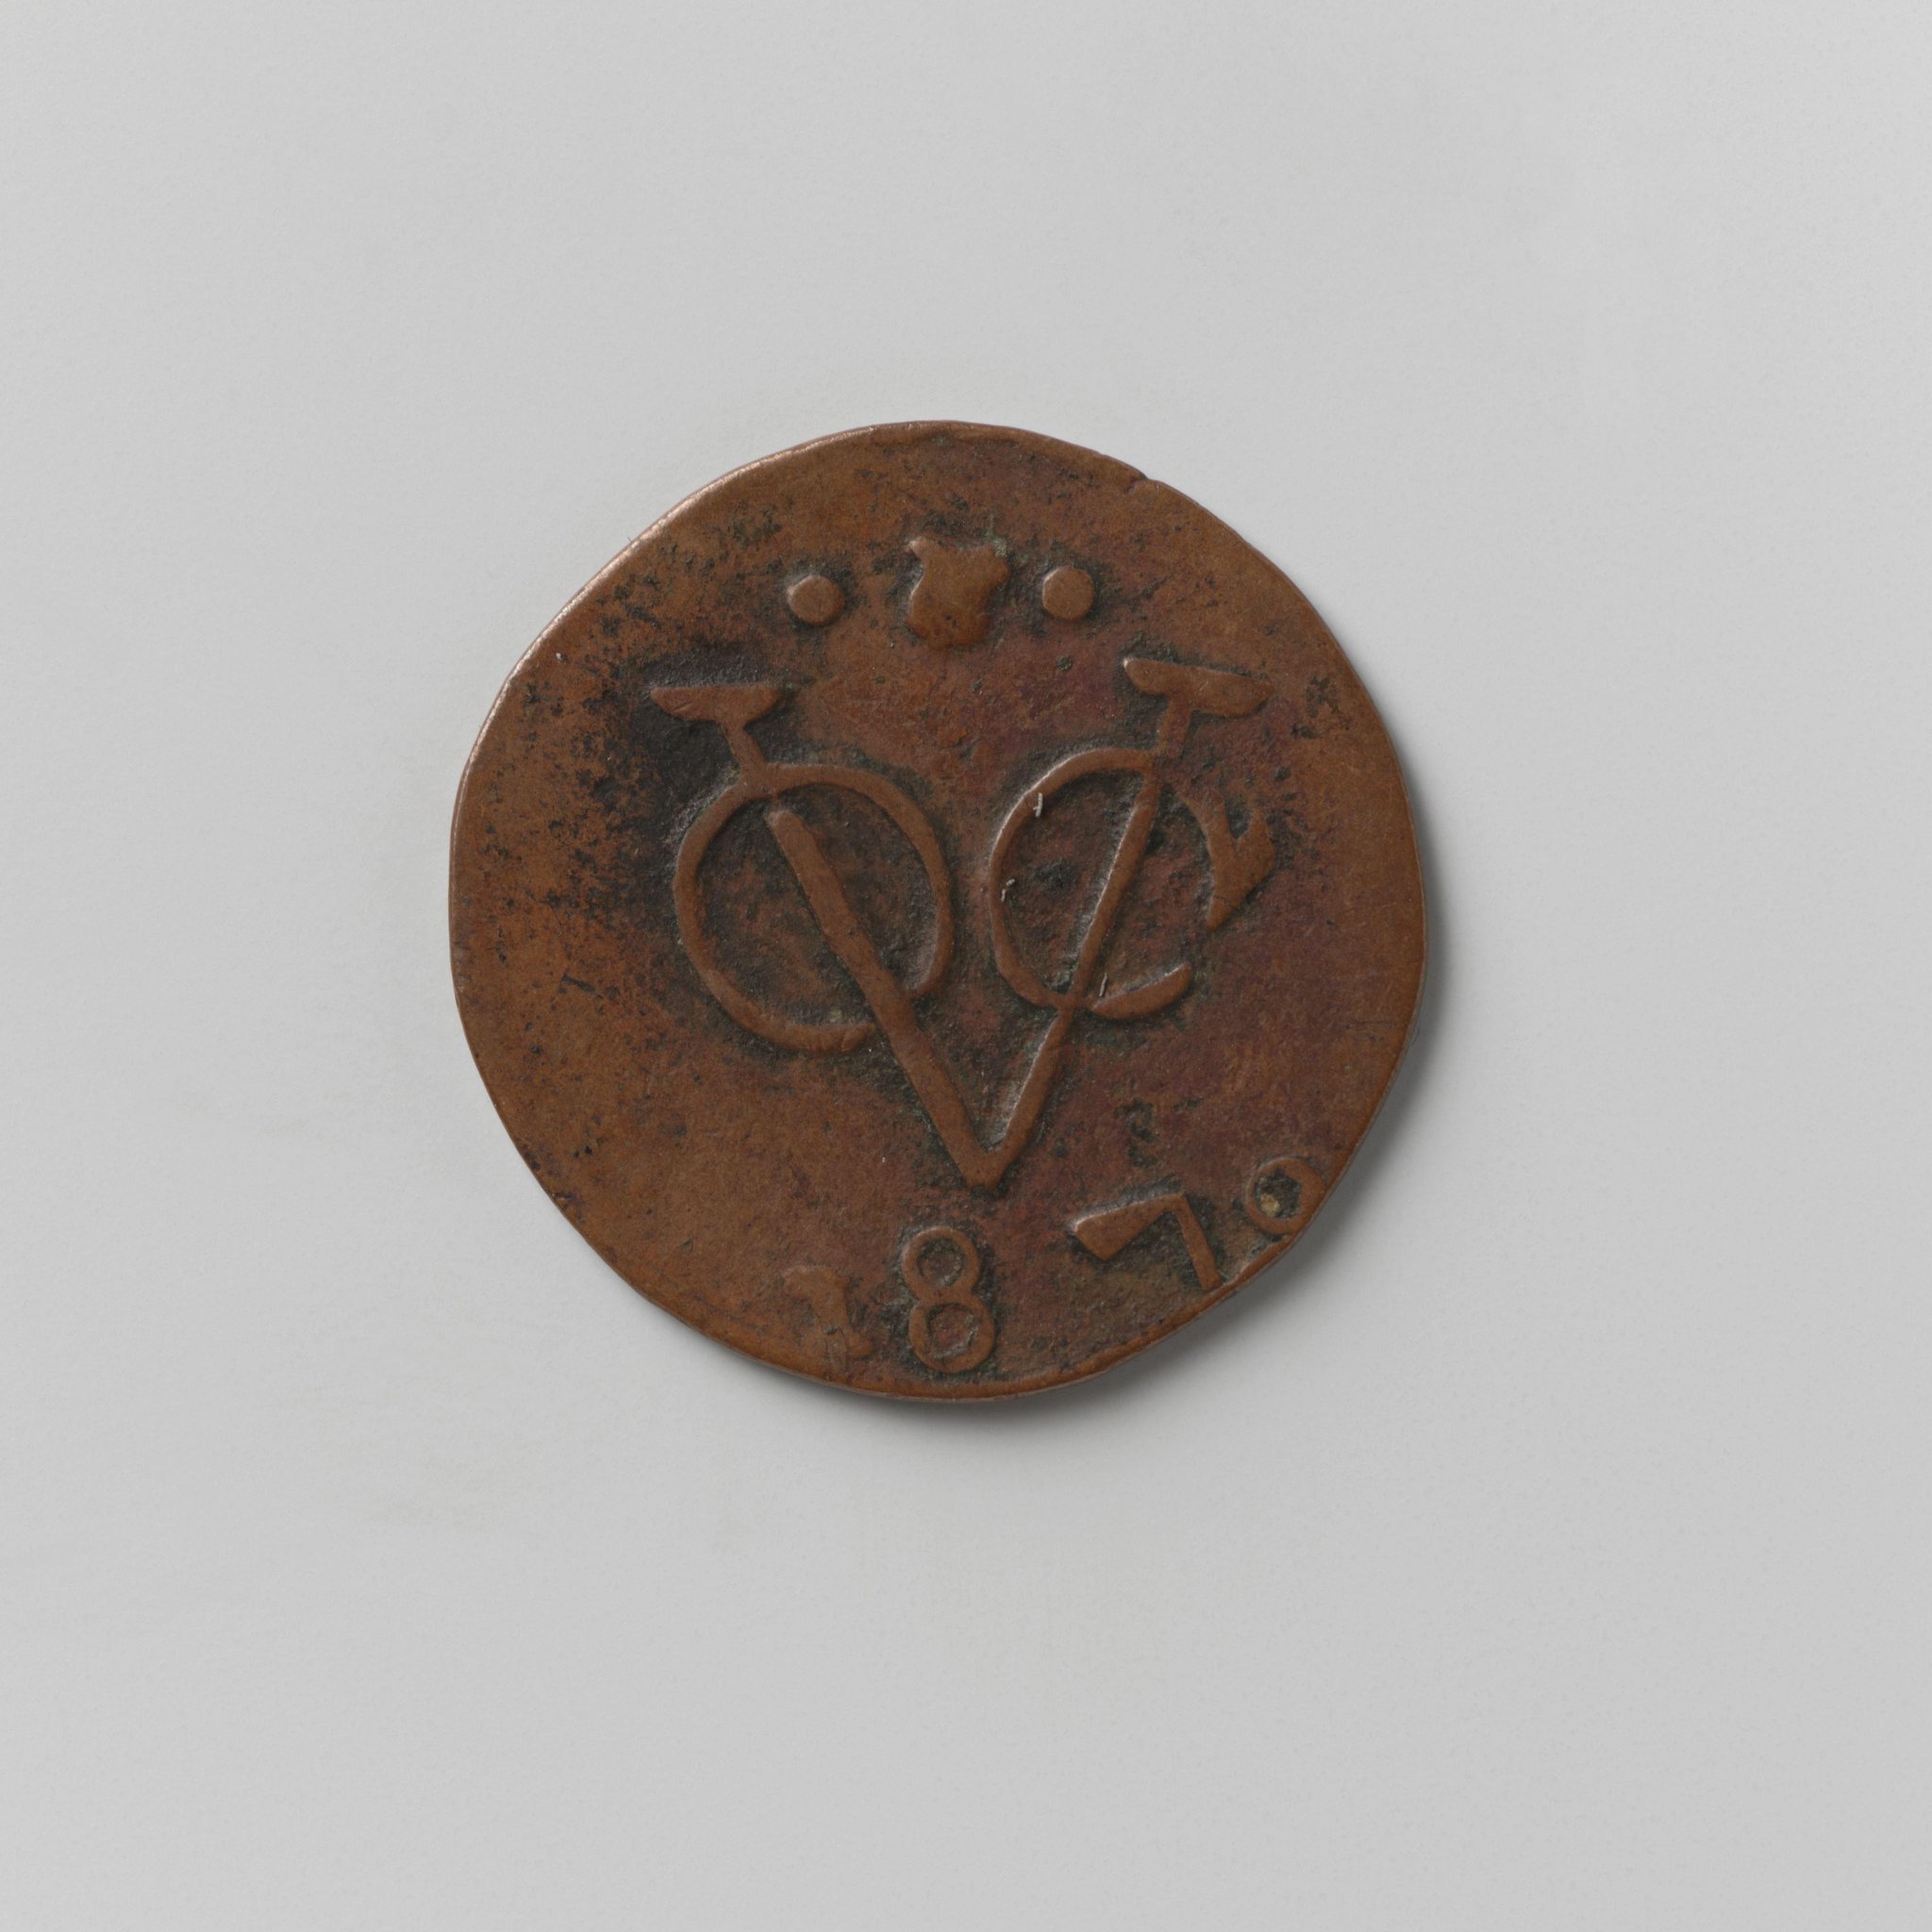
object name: coin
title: Nabootsing van VOC- duit Utrecht, 1870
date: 1830-1870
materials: copper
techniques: striking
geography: banjarmasin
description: Koperen munt. Nabootsing van duit van de VOC uit Utrecht. Voorzijde: door twee leeuwen gehouden wapenschild van Utrecht, waaronder versiering. Keerzijde: monogram van de VOC, waarboven muntteken en waaronder fictief jaartal.